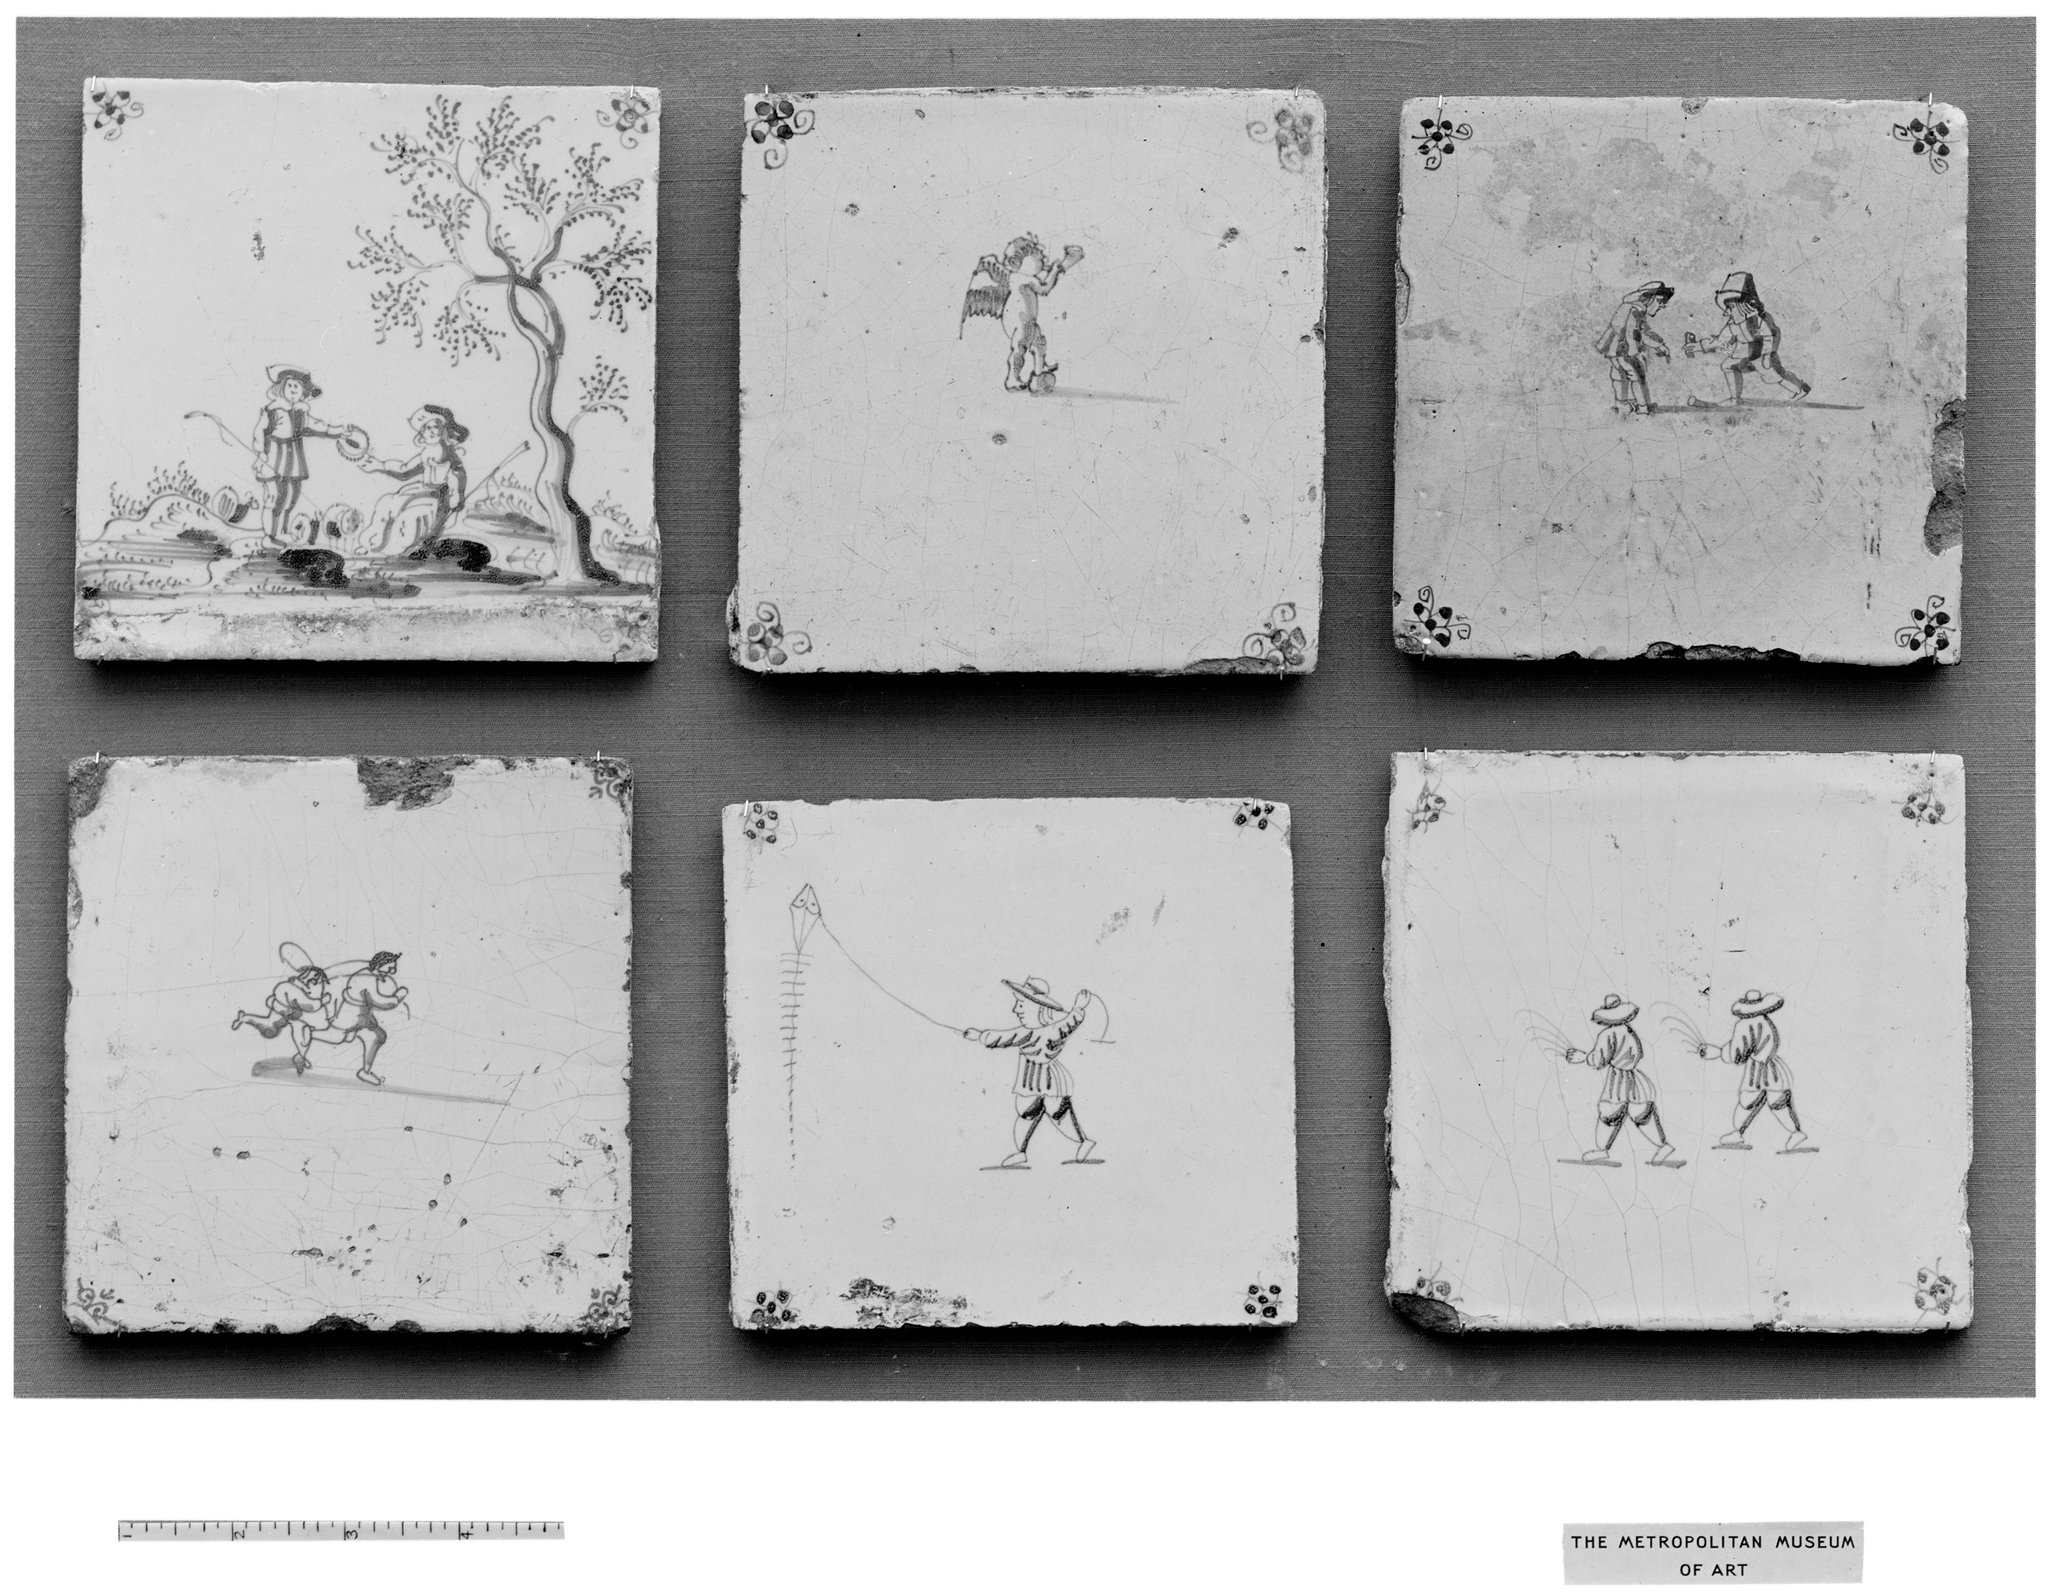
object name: tile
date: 1701-1800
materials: earthenware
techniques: glazing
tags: men,women